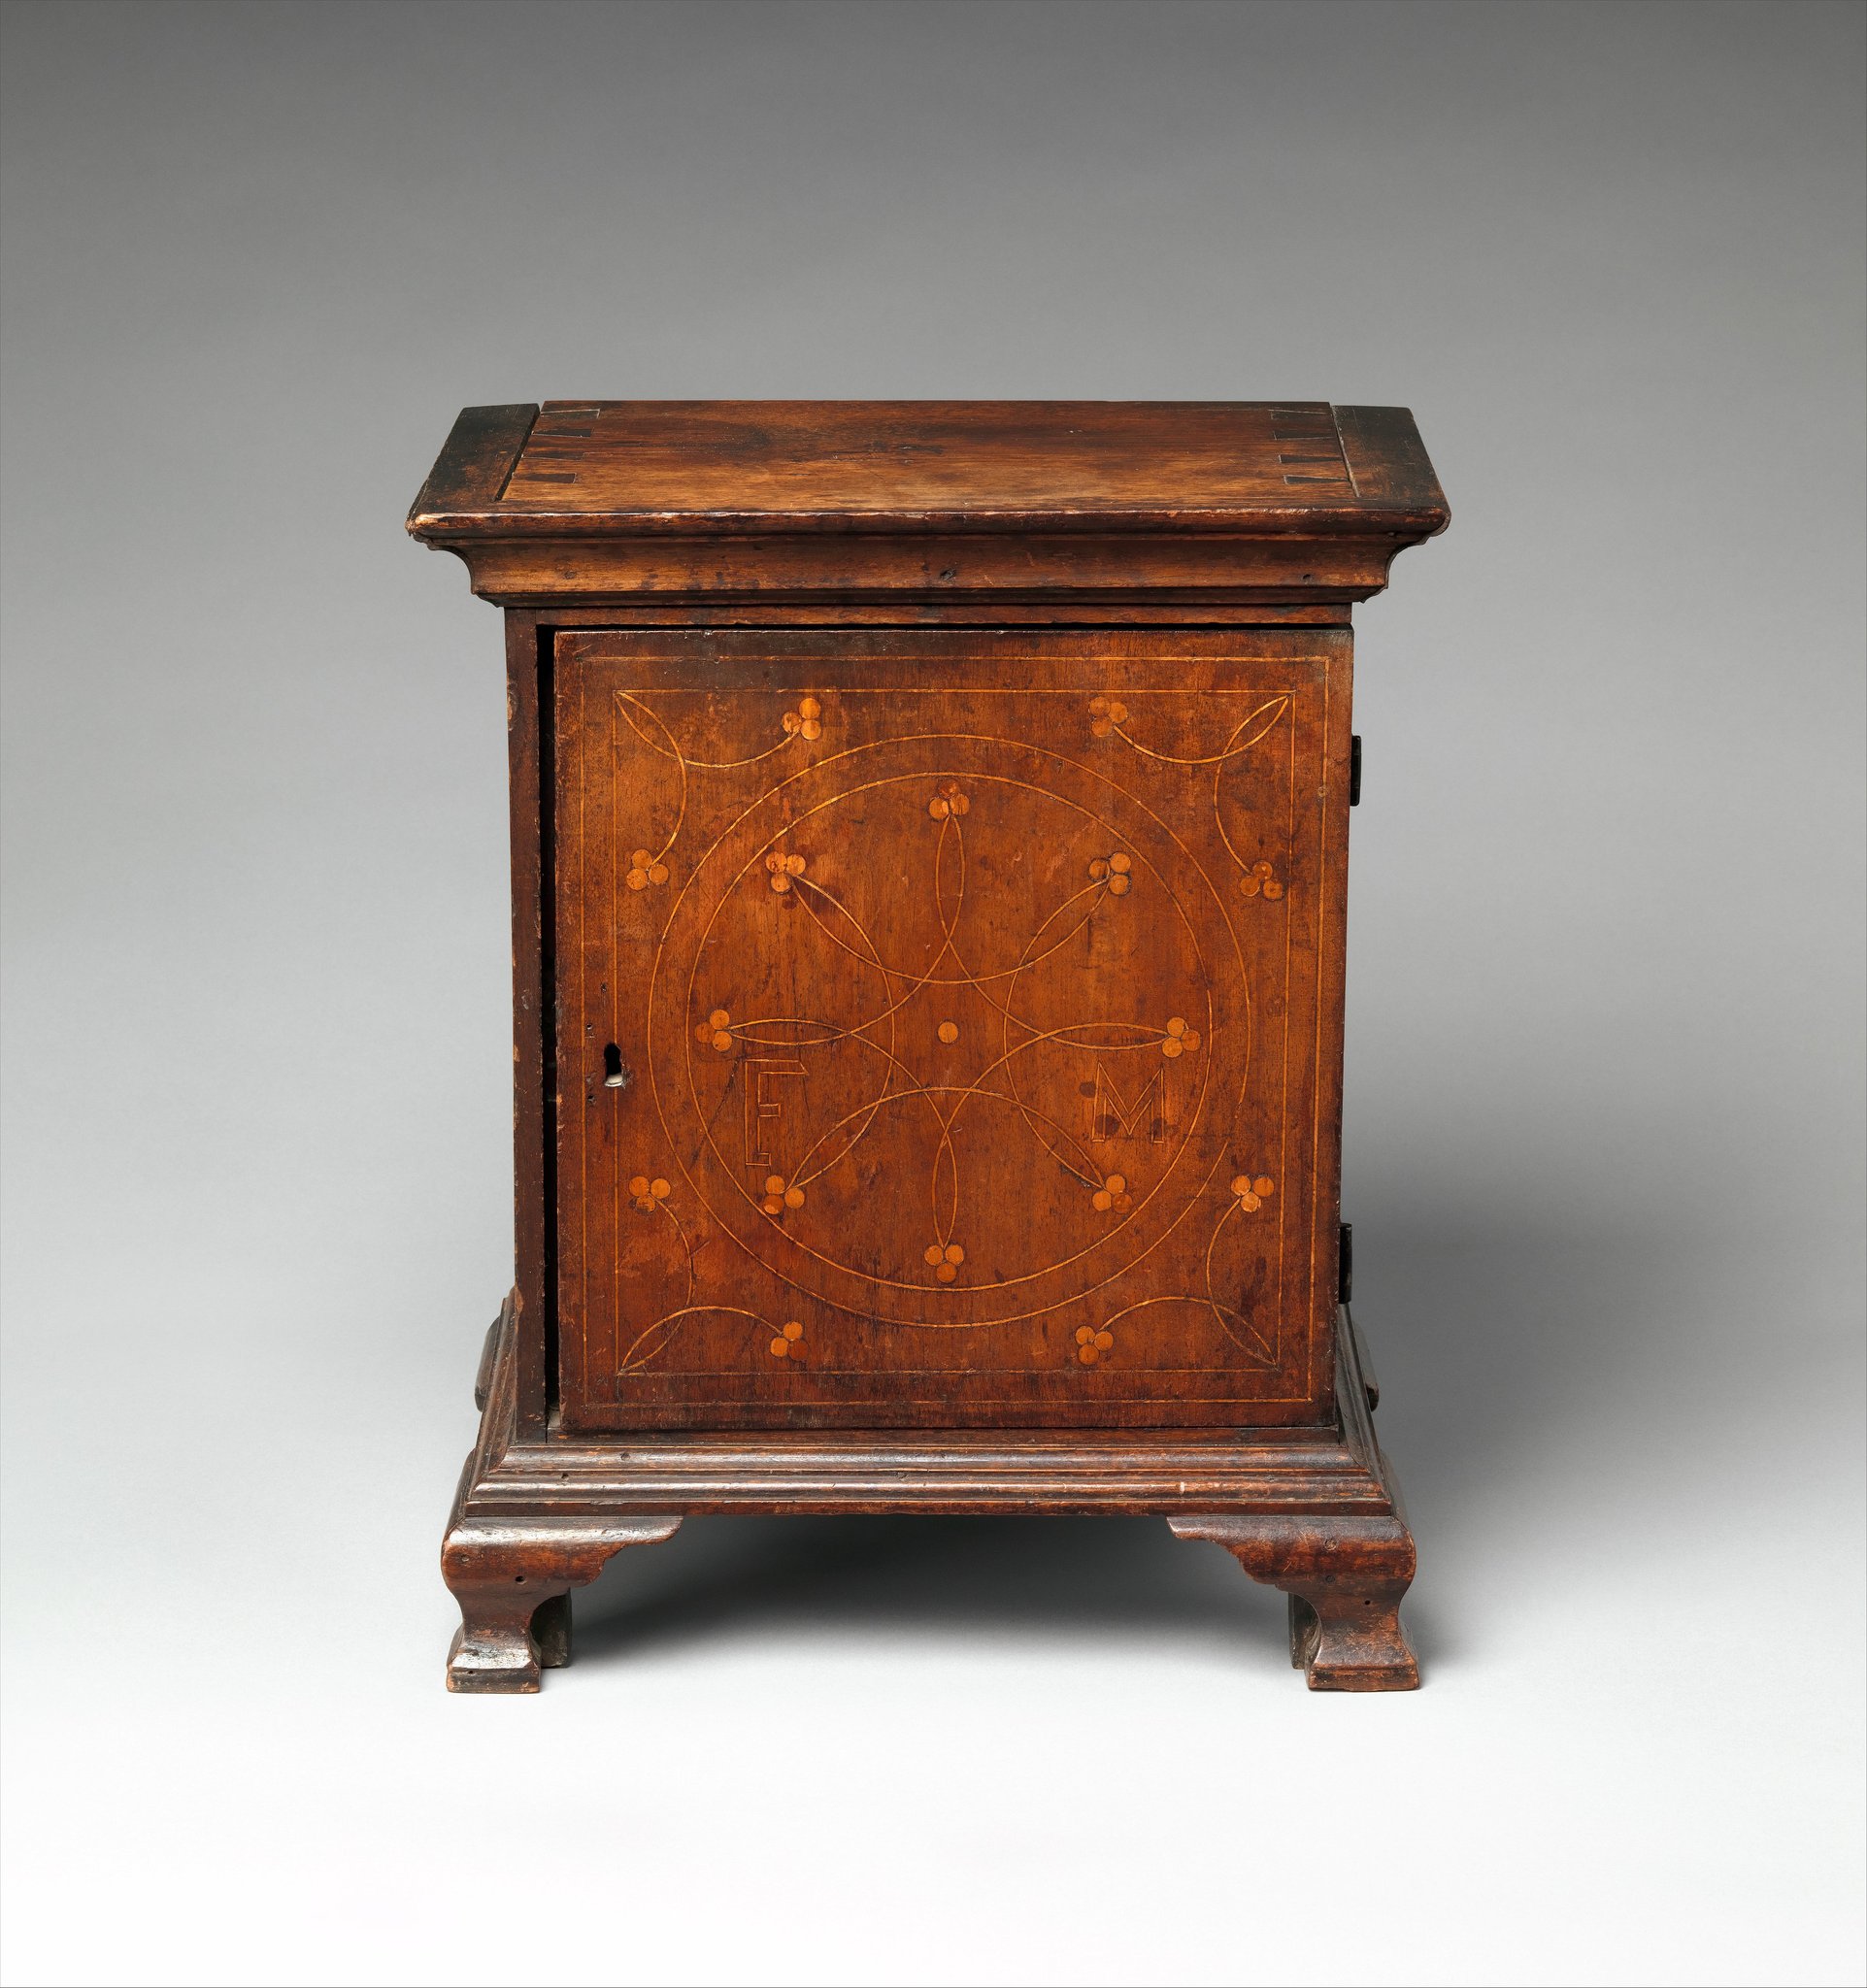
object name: spice box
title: Queen Anne spice box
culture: american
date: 1750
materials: wood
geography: united states